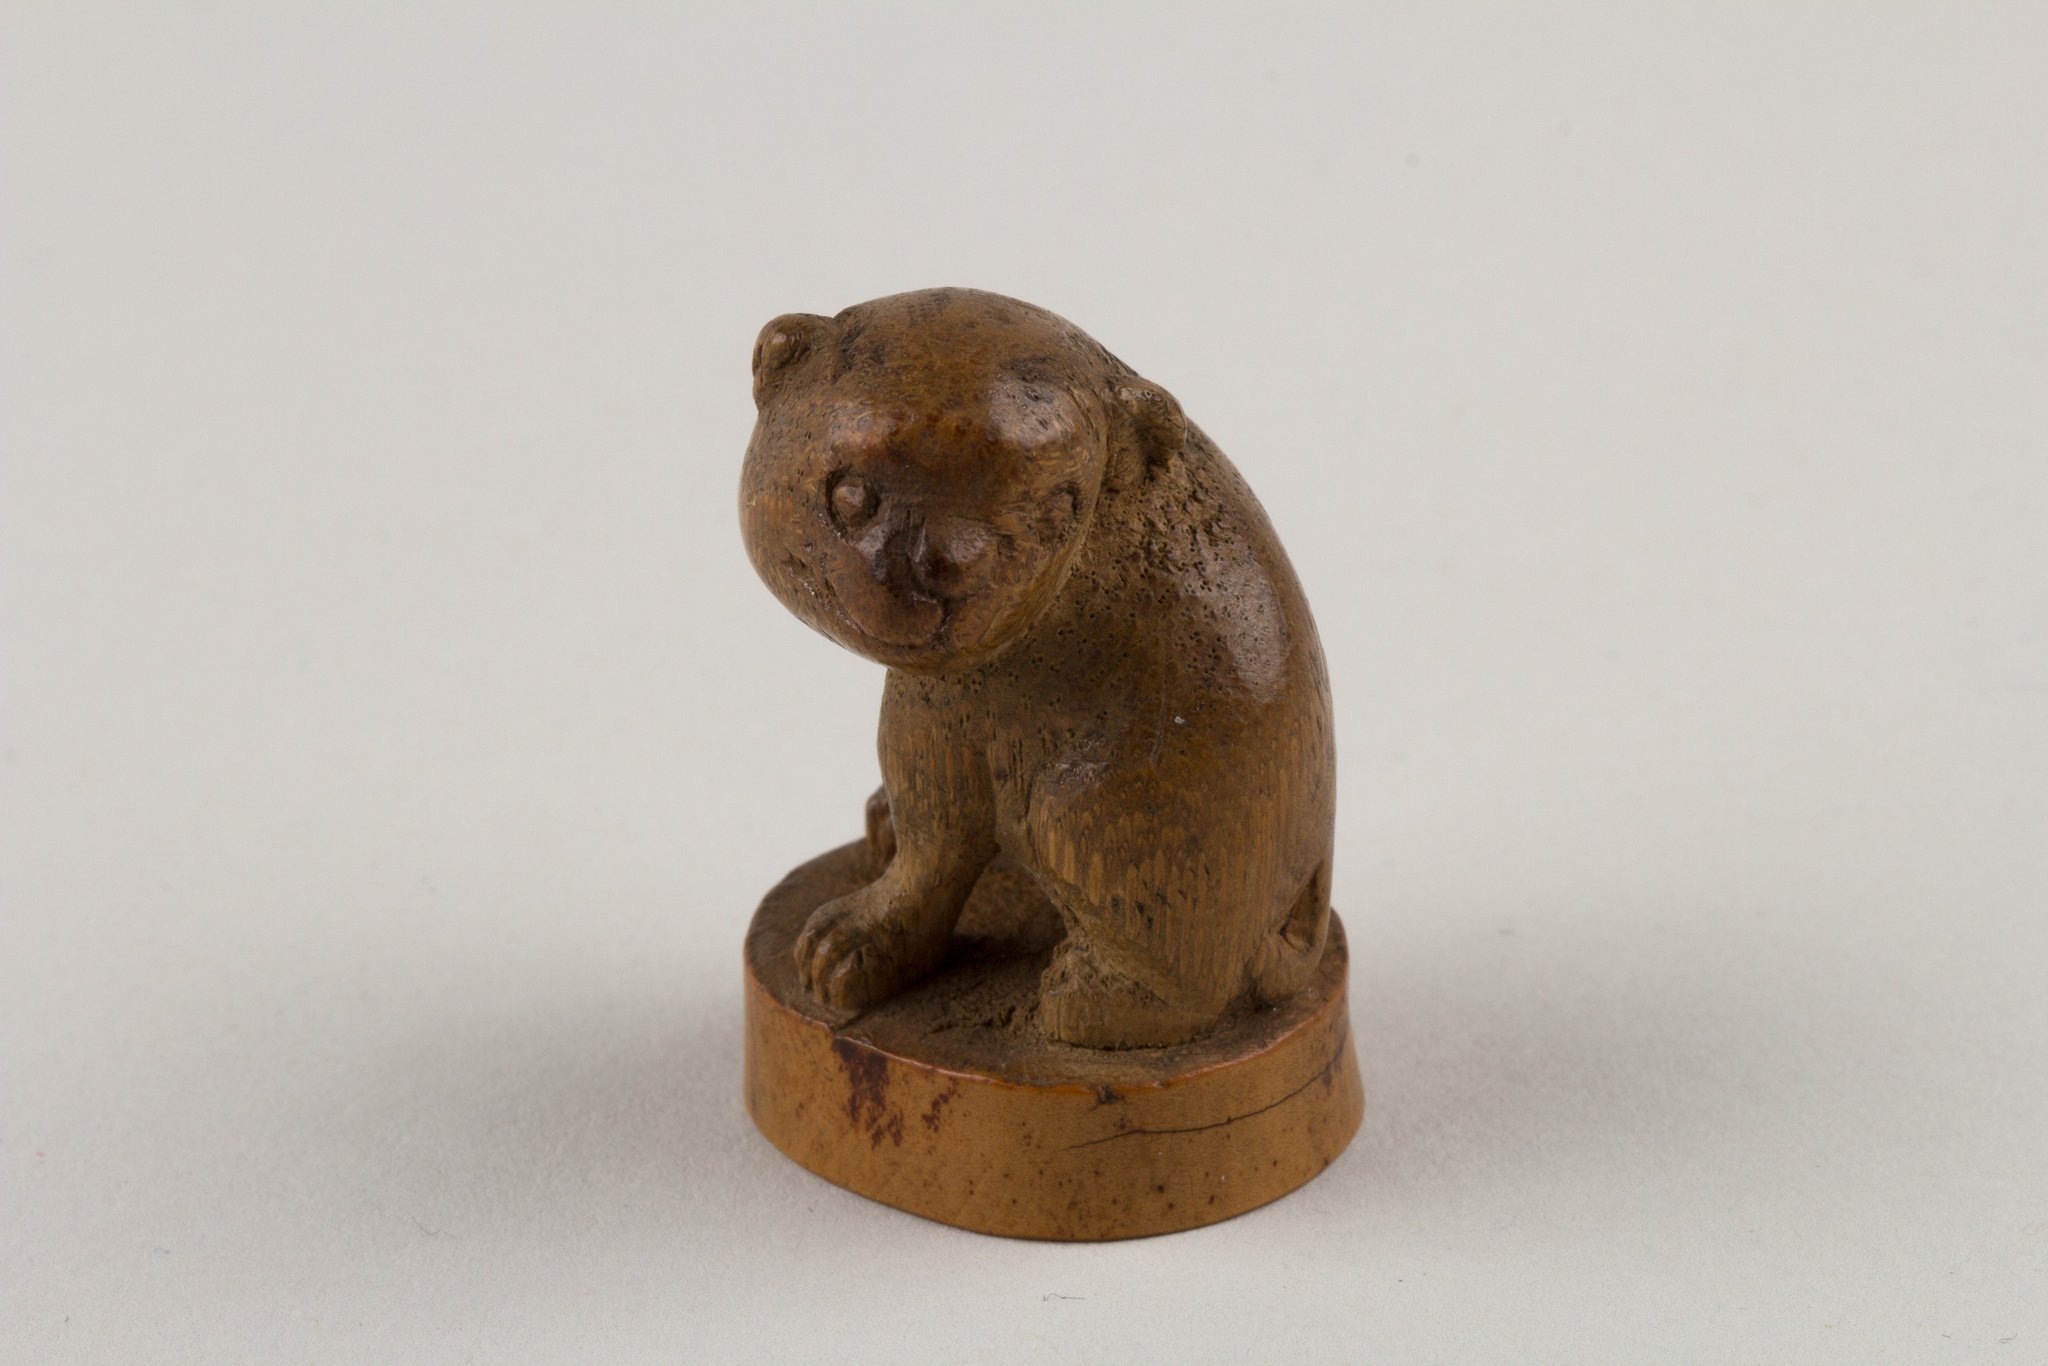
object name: netsuke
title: Netsuke: Seal in the Form of a Seated Pug-Dog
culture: japanese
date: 1615-1868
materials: bamboo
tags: dogs